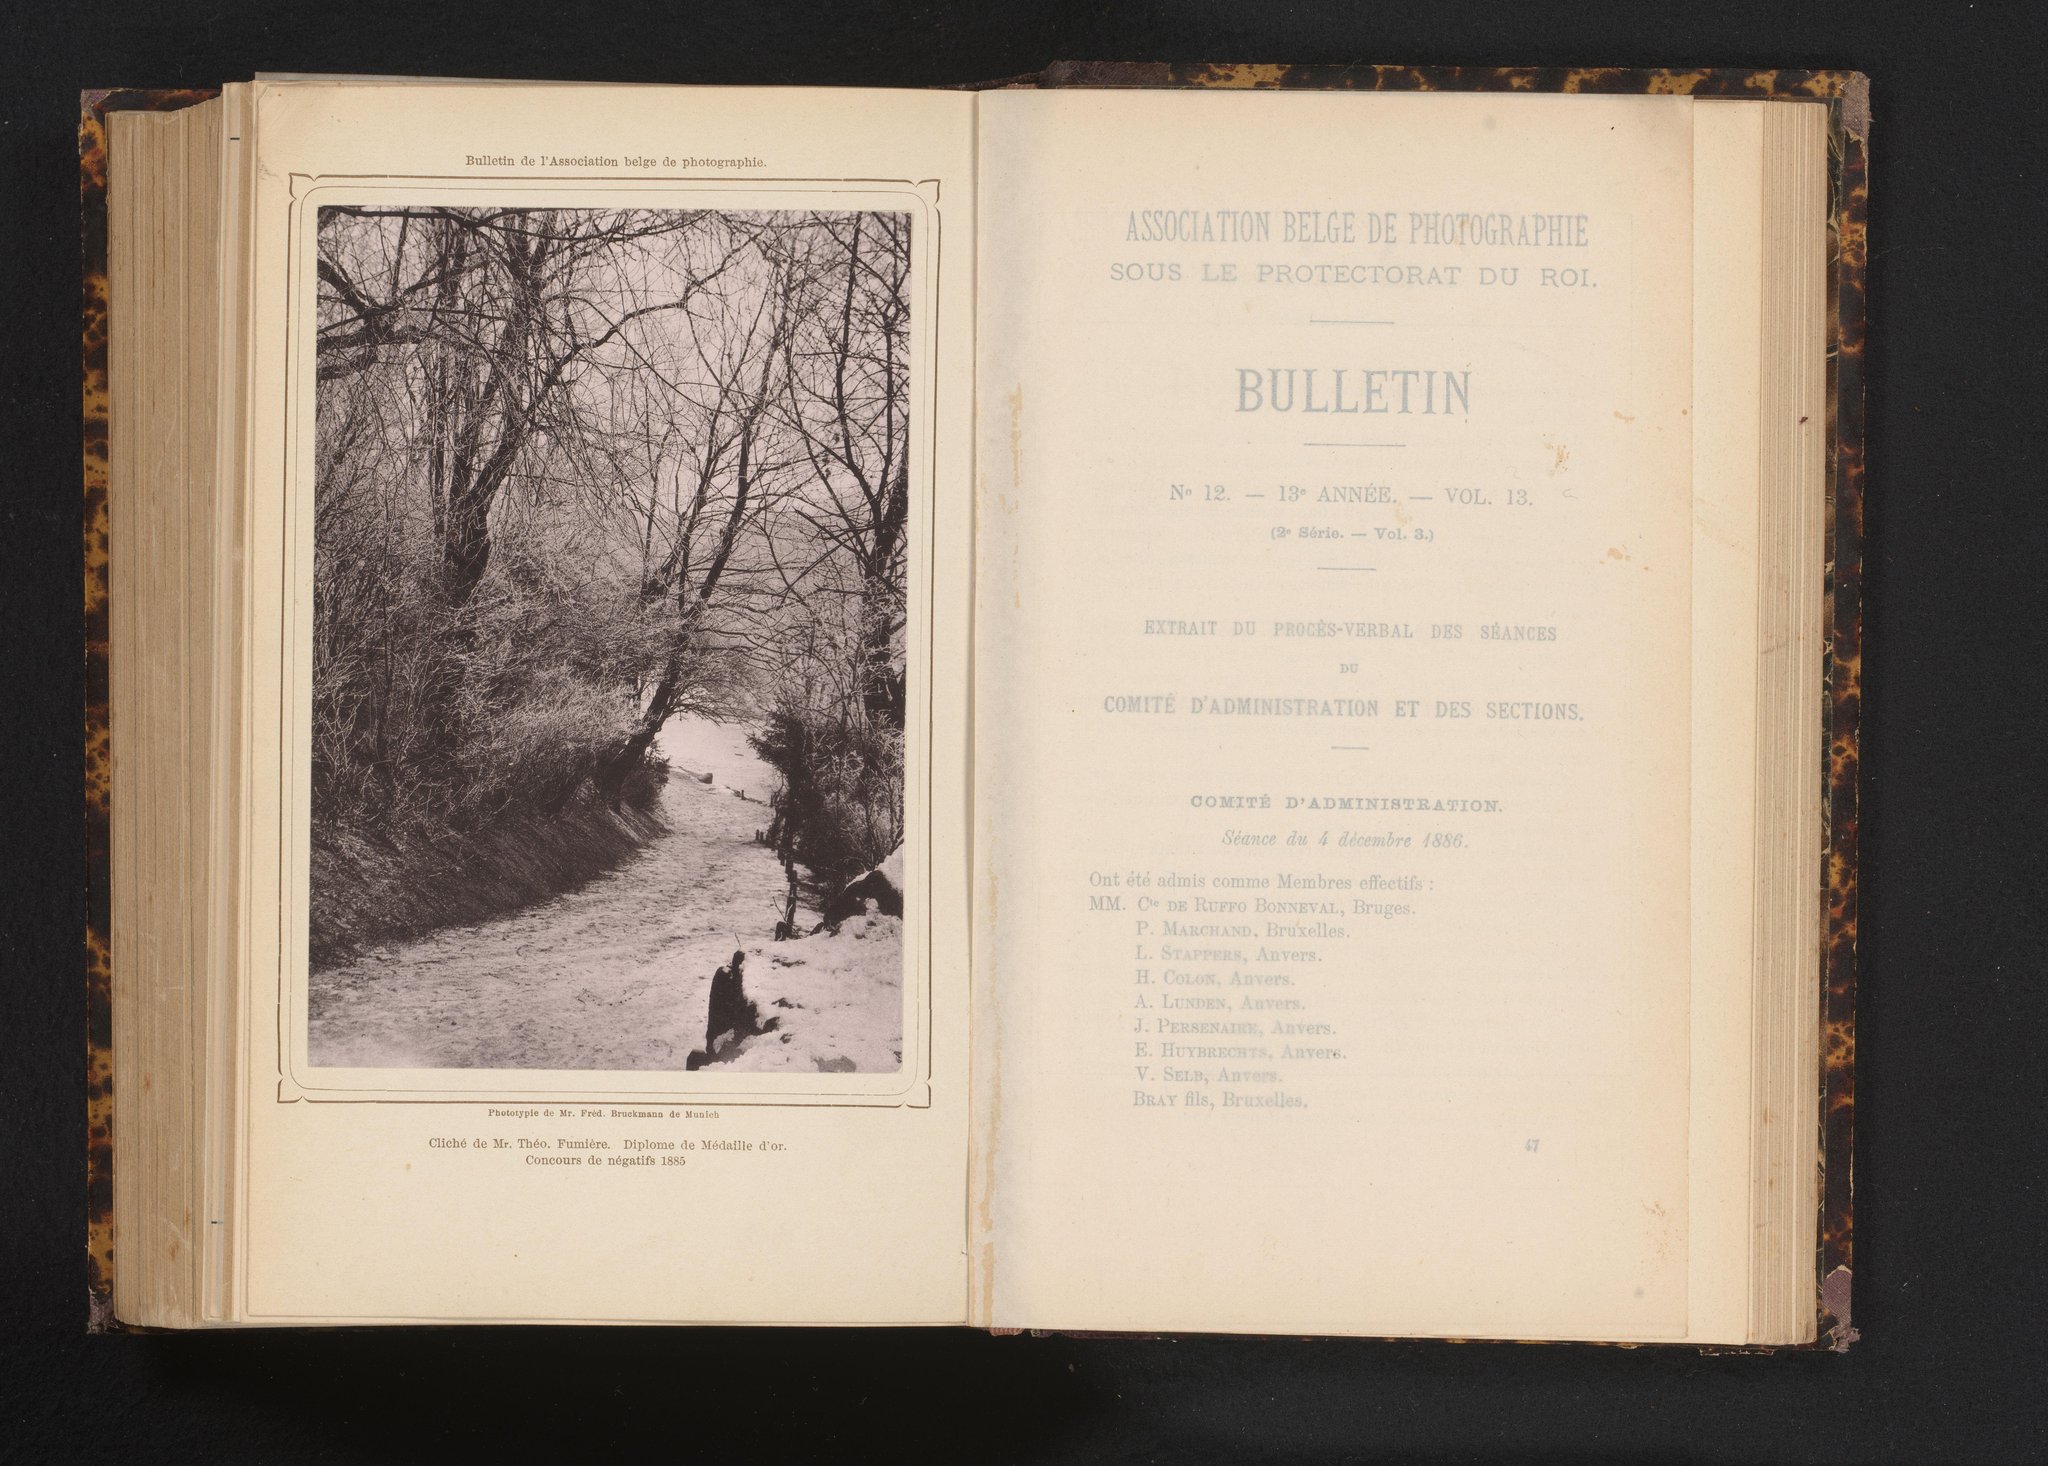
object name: photomechanical print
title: Besneeuwd bospad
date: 1881-1886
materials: paper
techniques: photograph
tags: forest path or lane, snow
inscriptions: inscription: ‘Bulletin de l'association belge de photographie/ Concours de négatifs 1885.’